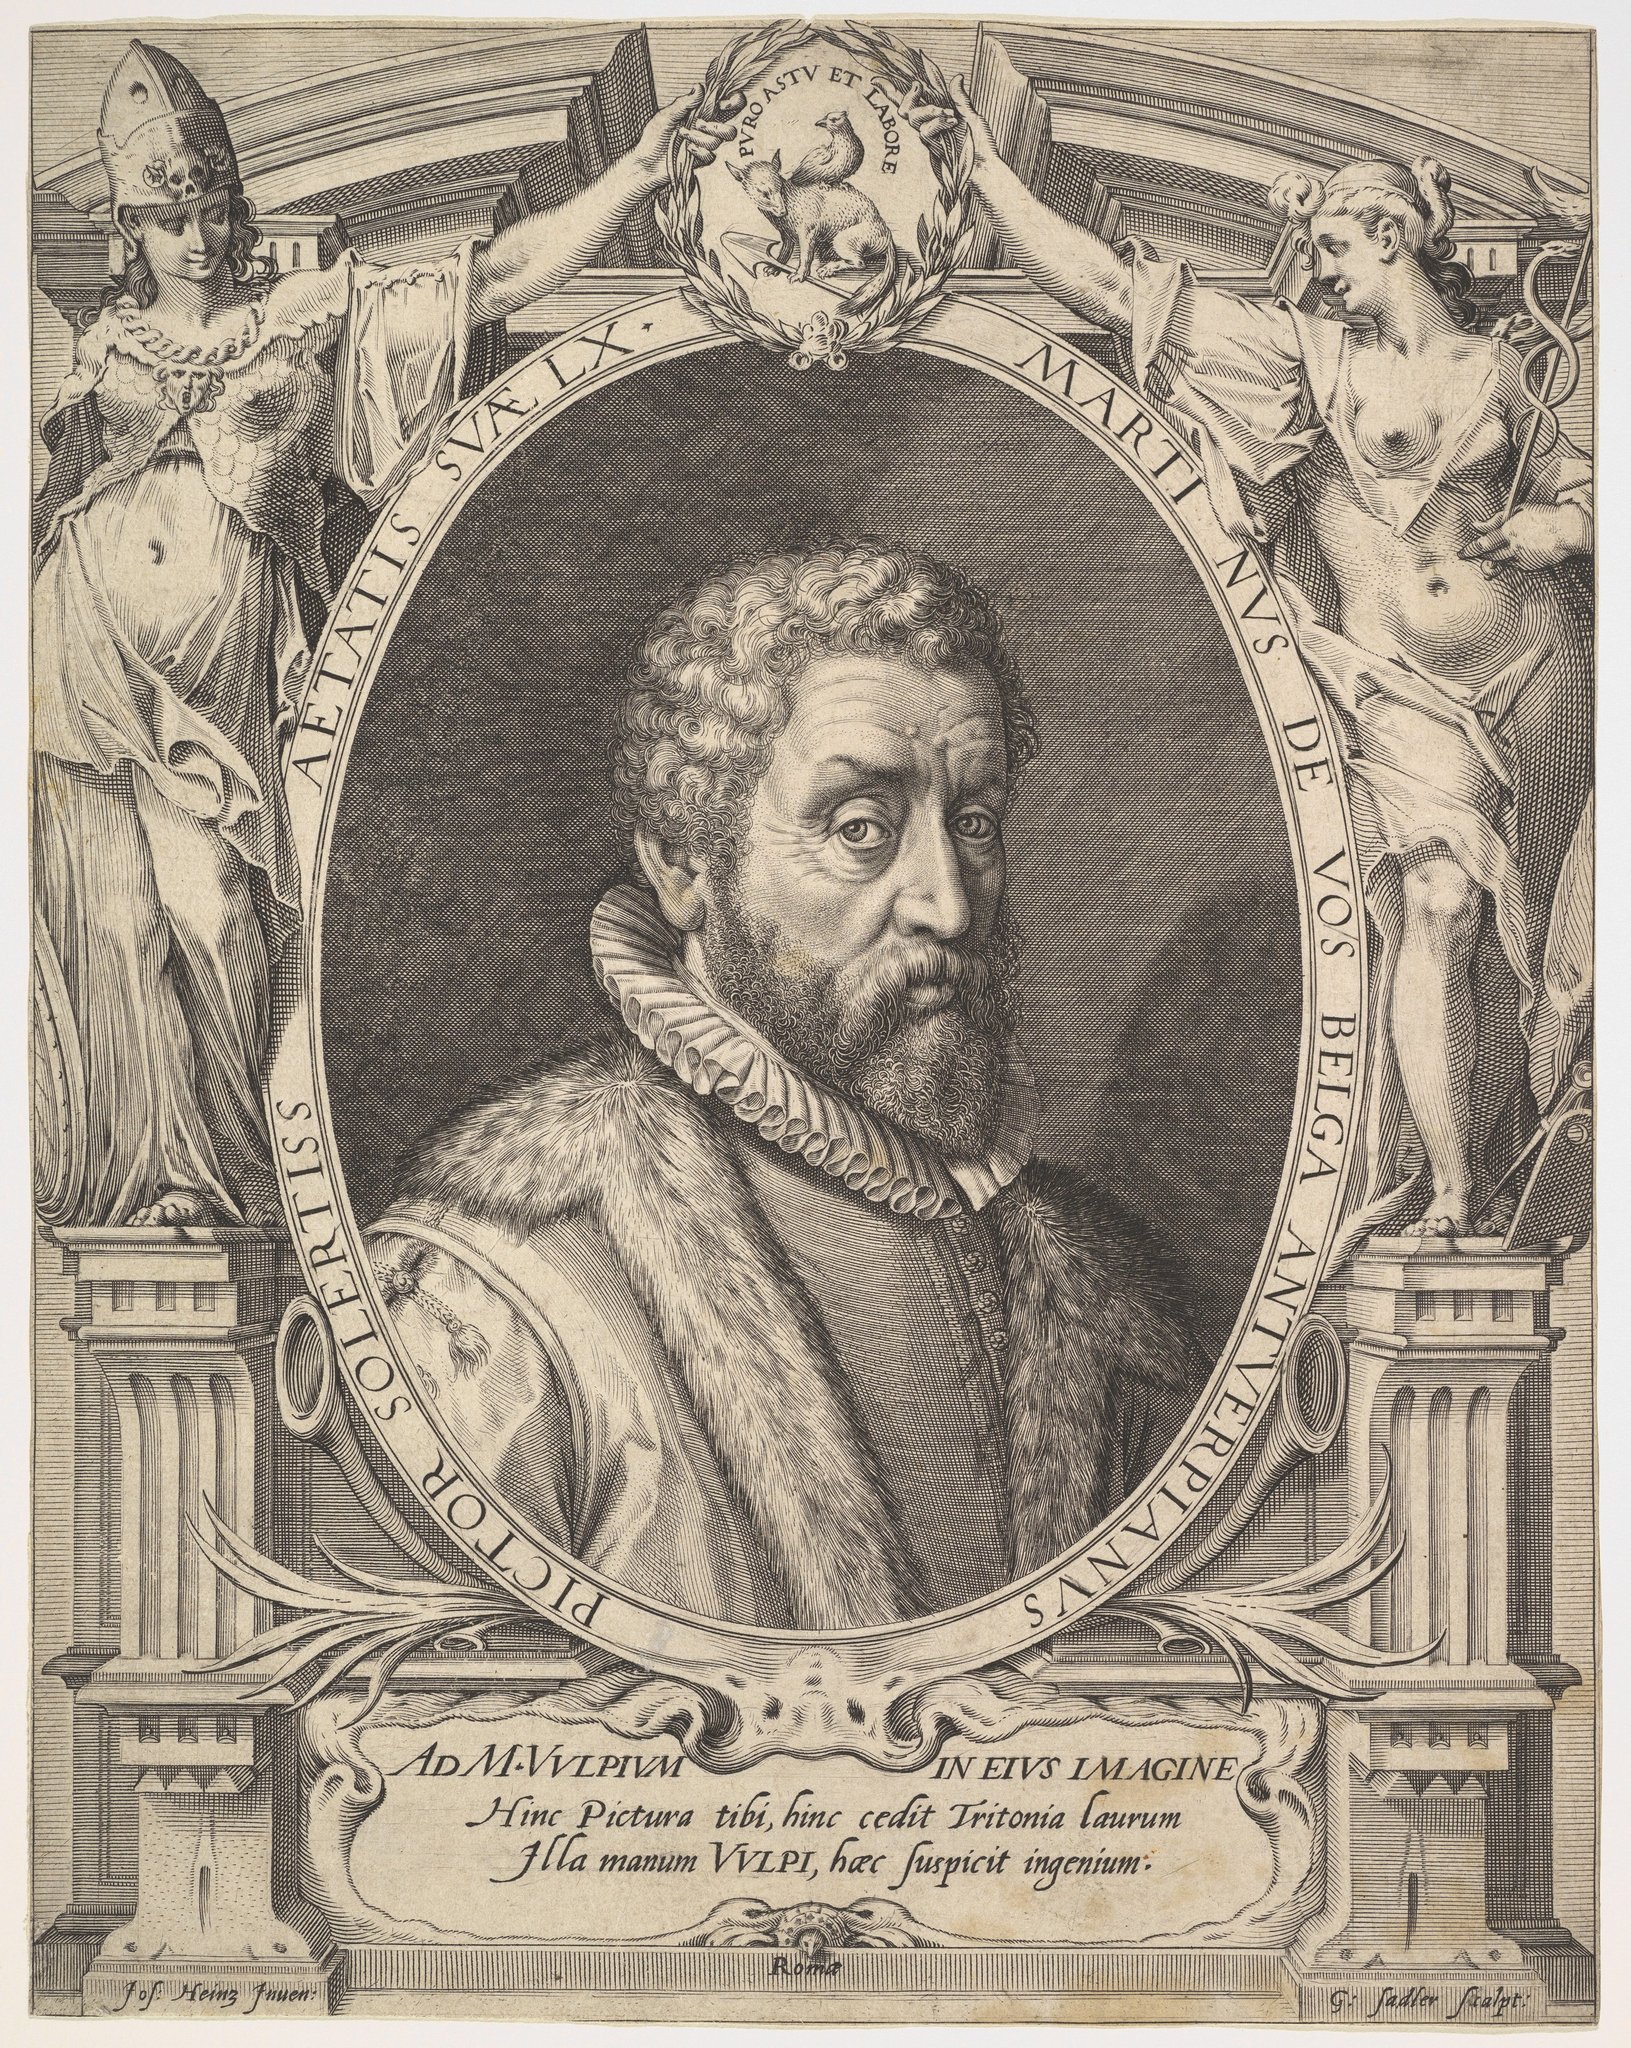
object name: print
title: Maerten de Vos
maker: aegidius sadeler (ii)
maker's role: artist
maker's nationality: flemish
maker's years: 1568-1629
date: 1570-1629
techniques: engraving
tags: men,portraits